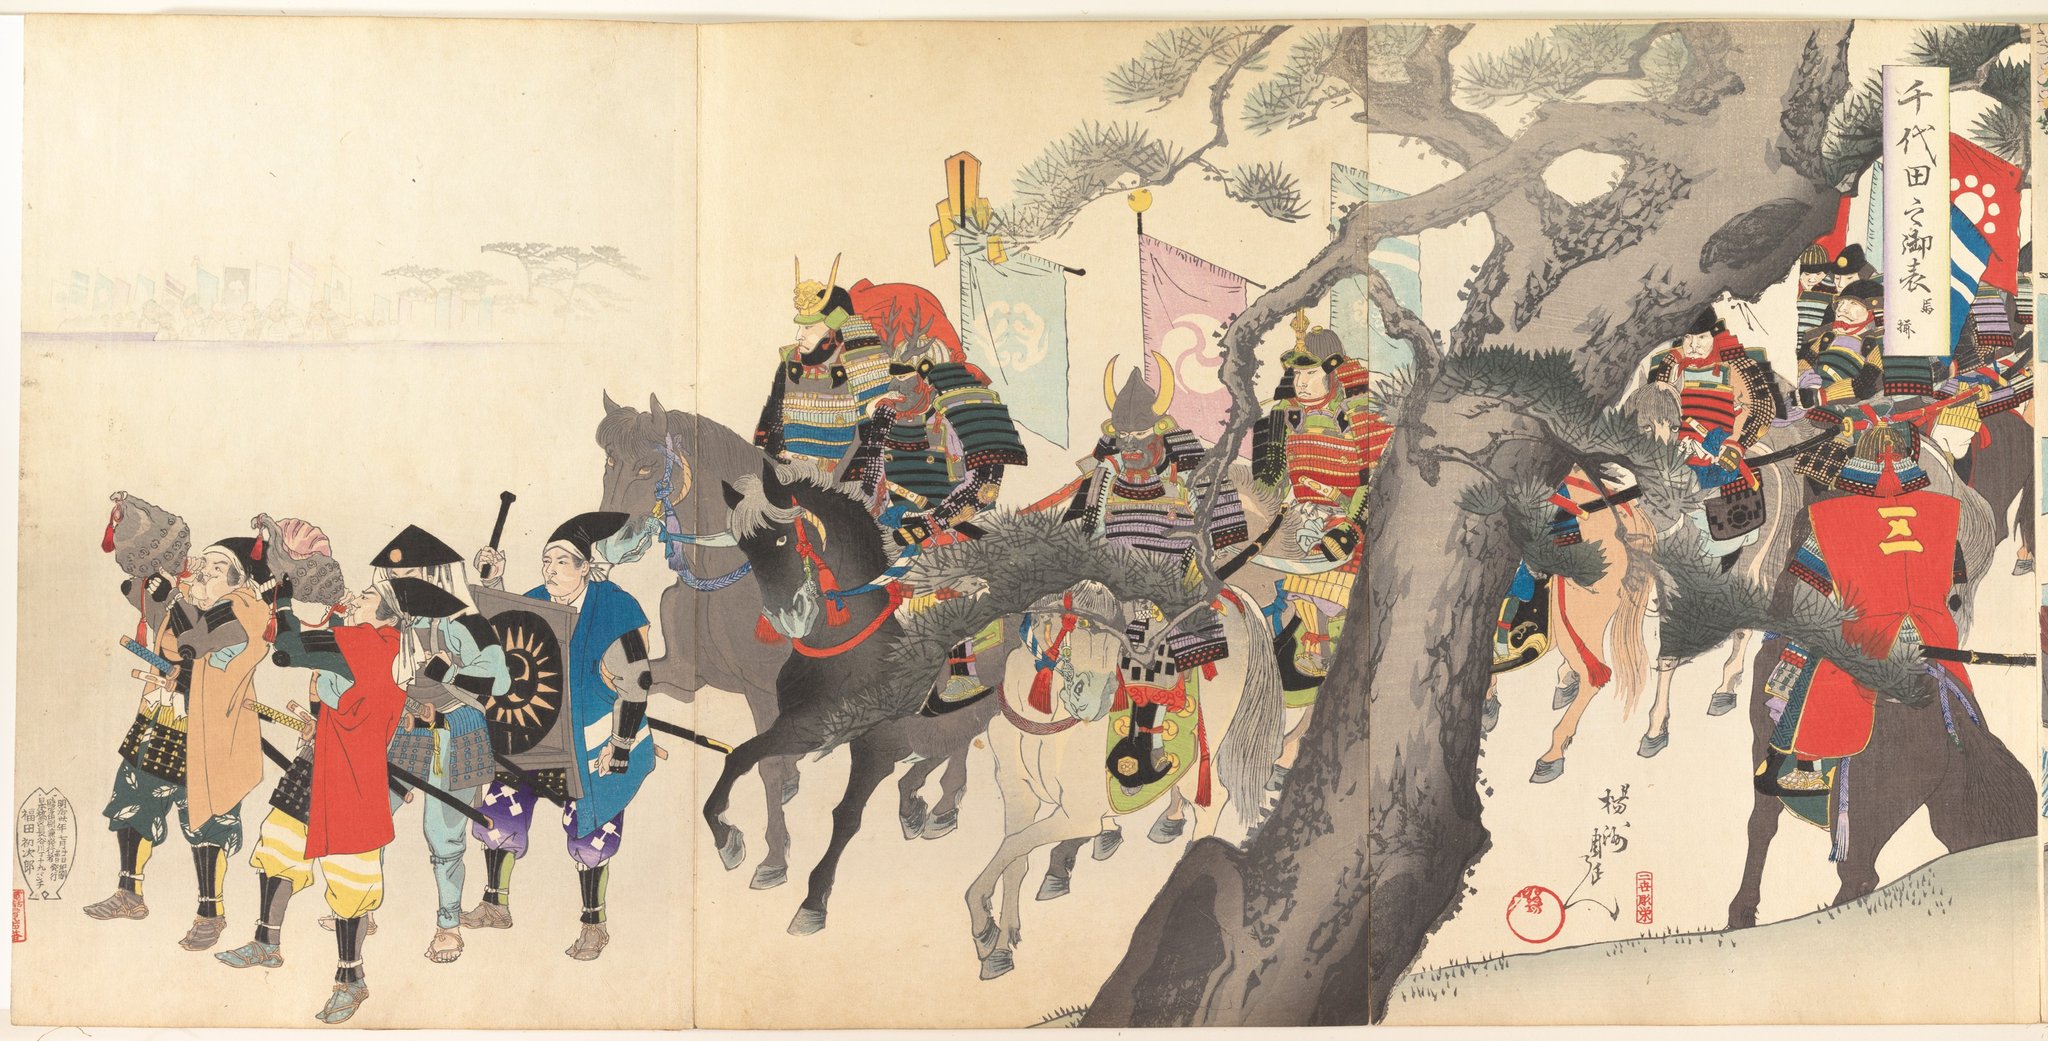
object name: print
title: Chiyoda Castle (Album of Men)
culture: japanese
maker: yōshū (hashimoto) chikanobu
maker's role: artist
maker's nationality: japanese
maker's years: 1838-1912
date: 1897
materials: ink, paper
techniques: woodblock print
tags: weapons,swords,men,horses